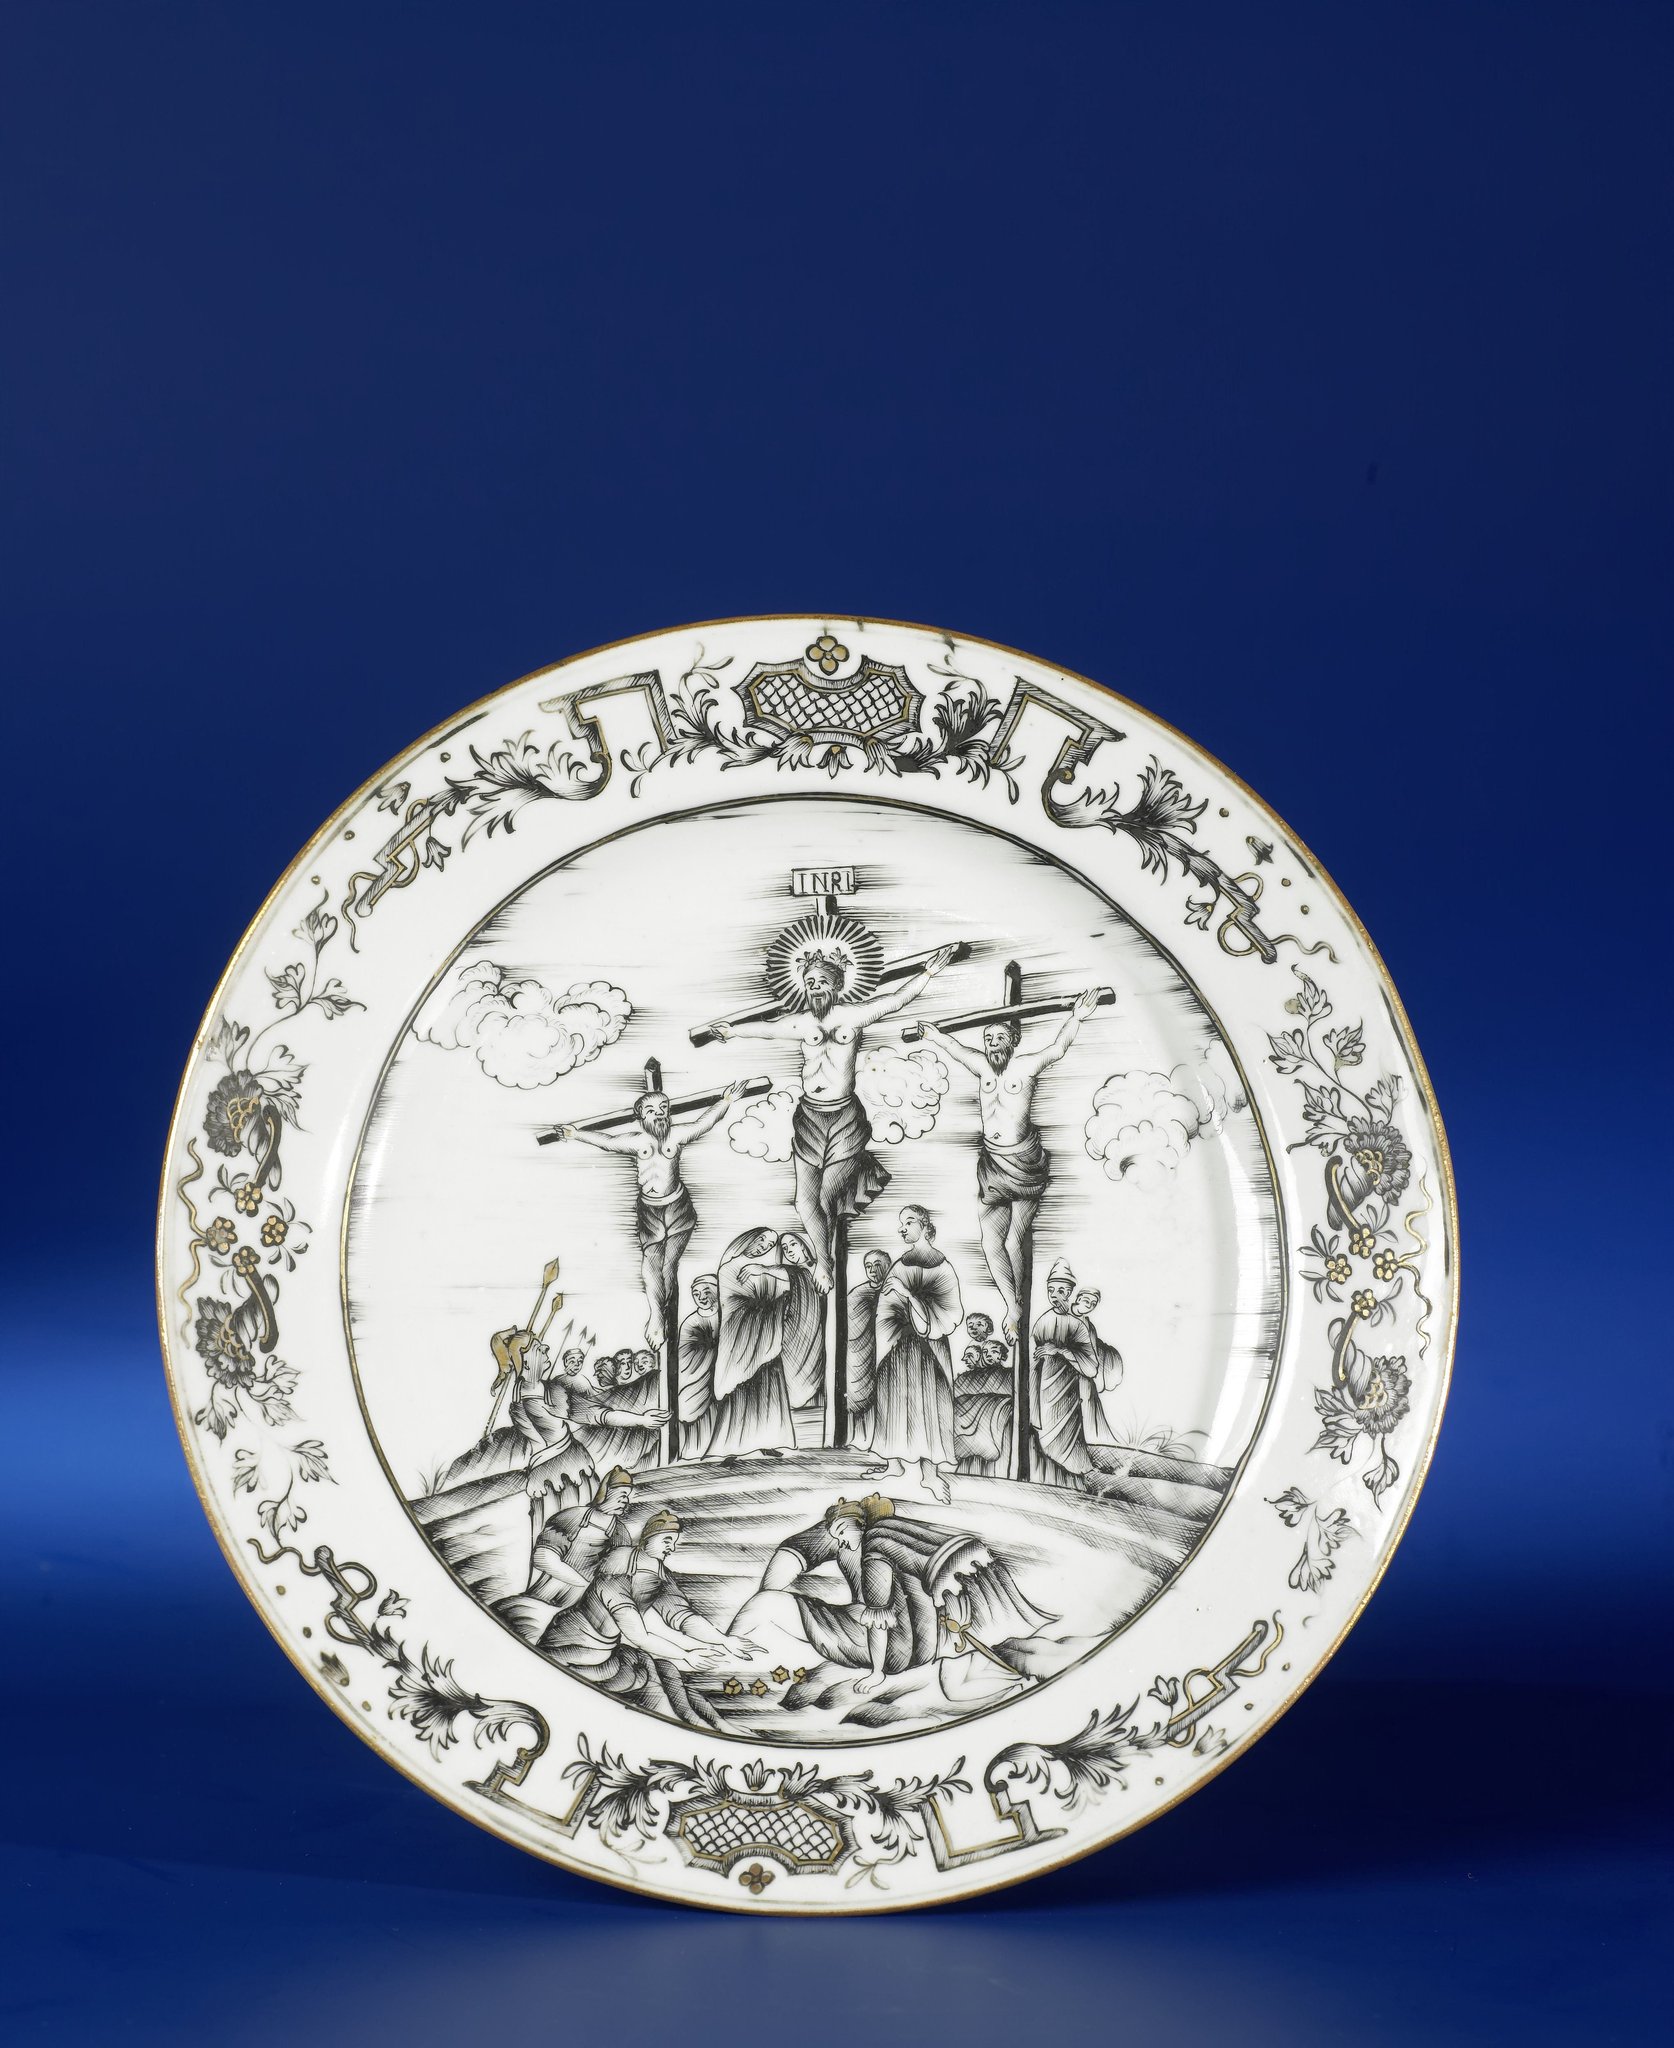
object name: plate dish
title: Plate with an image of The Crucifixion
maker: Anonymous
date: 1740-1760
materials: glaze, gold, paint, porcelain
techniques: firing, gilding, turning, vitrification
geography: amsterdam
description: Bord op een voetring, met een platte rand. Gedecoreerd in encre de Chine en goud met een voorstelling van de Kruisiging van Christus. De rand is gedecoreerd met een Laub- und Bandelwerk band, in de stijl van het Weense Du Paquier porselein. Deze rand bestaat uit zich kruisende lijnen, met ertussen een figuurtje. De lijnen lopen uit in een bladachtig motief. Tussen 1745 en 1750 waren religieuze scènes zeer populair. Naast de Kruisiging werden ook de Geboorte, de Opstanding en de Hemelvaart veelvuldig op porselein aangebracht, zowel polychroom als in encre de Chine. Tenminste acht varianten van de randen zijn bekend. De polychrome exemplaren bij deze borden zijn zeldzamer dan de exemplaren in encre de Chine. Naast borden zijn er ook onderdelen van thee-, koffie- en chocoladeserviezen met deze vier voorstellingen bekend. Kommen, soepborden of schalen en andere serviesonderdelen ontbreken. Aangenomen kan worden dat de borden voornamelijk een decoratieve functie hadden. In het midden is Christus aan het kruis afgebeeld, geflankeerd door de twee misdadigers.Links van het kruis staat Maria, rechts is Johannes afgebeeld. Op de voorgrond soldaten die om de kleren van Christus dobbelen. De scènes in deze serie zijn nauwgezette kopieën van prenten die de Amsterdamse dichter en graveur Jan Luyken (1649-1712) maakte voor verschillende edities van de Lutherse Nederduytse Bijbel.